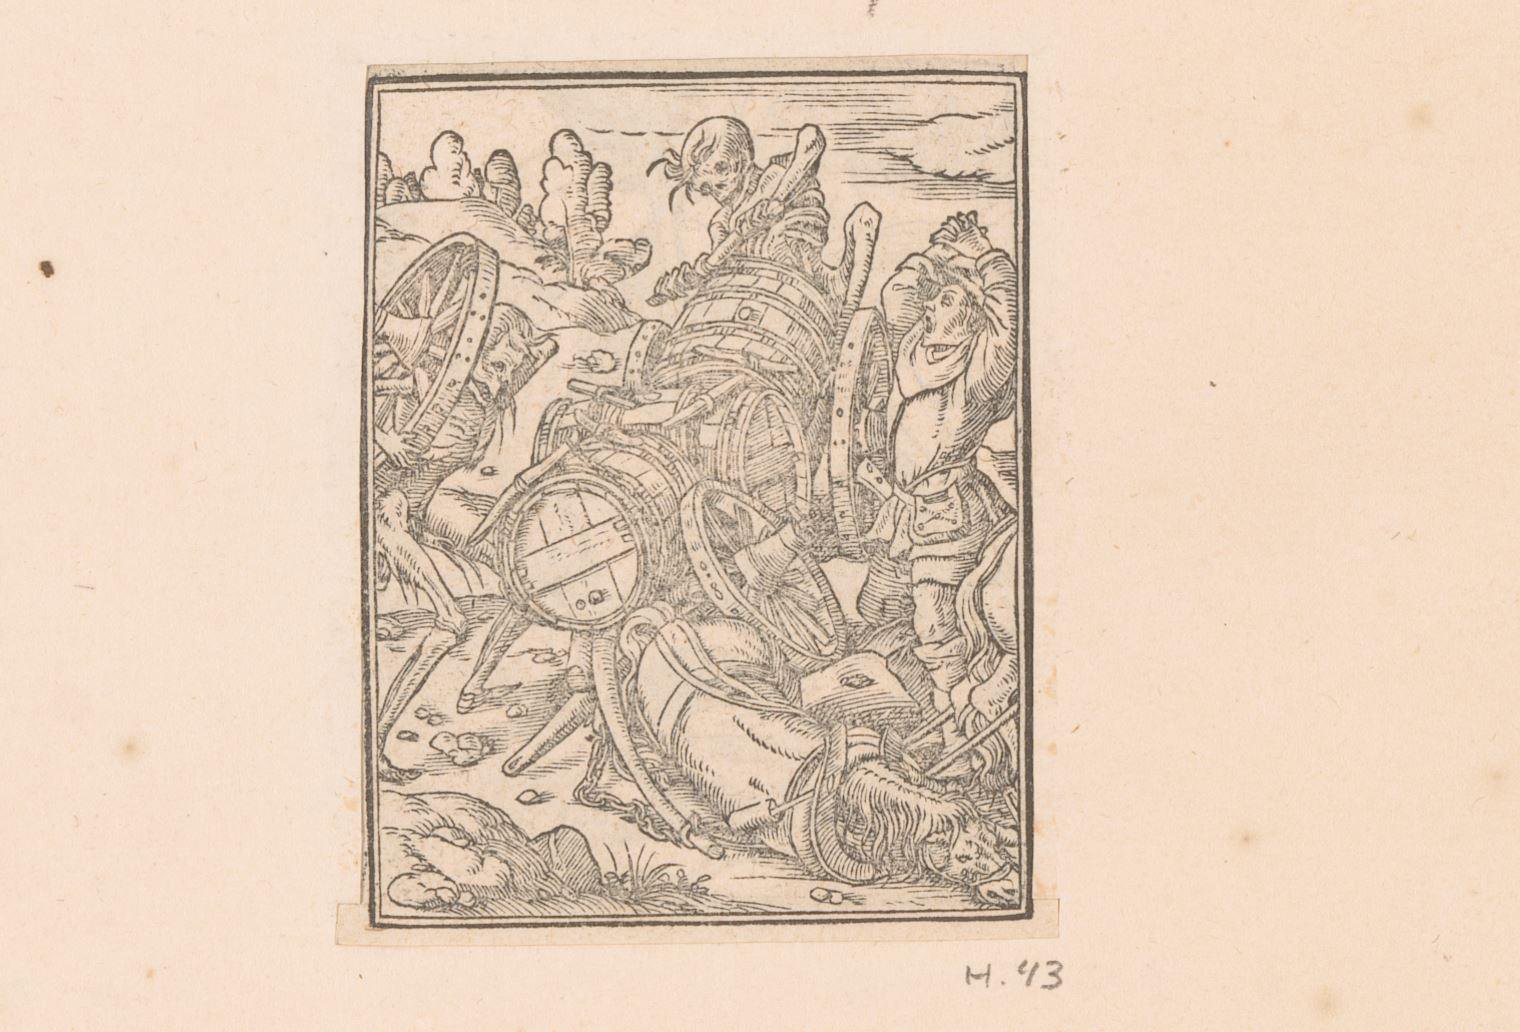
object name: book illustration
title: Voerman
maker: Anonymous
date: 1547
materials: paper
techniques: woodcut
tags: dance of death; death together with one or more human beings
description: Kopie van een prent van Hans Holbein de jongere uit 1538, voor het eerst gepubliceerd in: Imagines mortis (...). Lyon: Johannes Frellon, 1547.